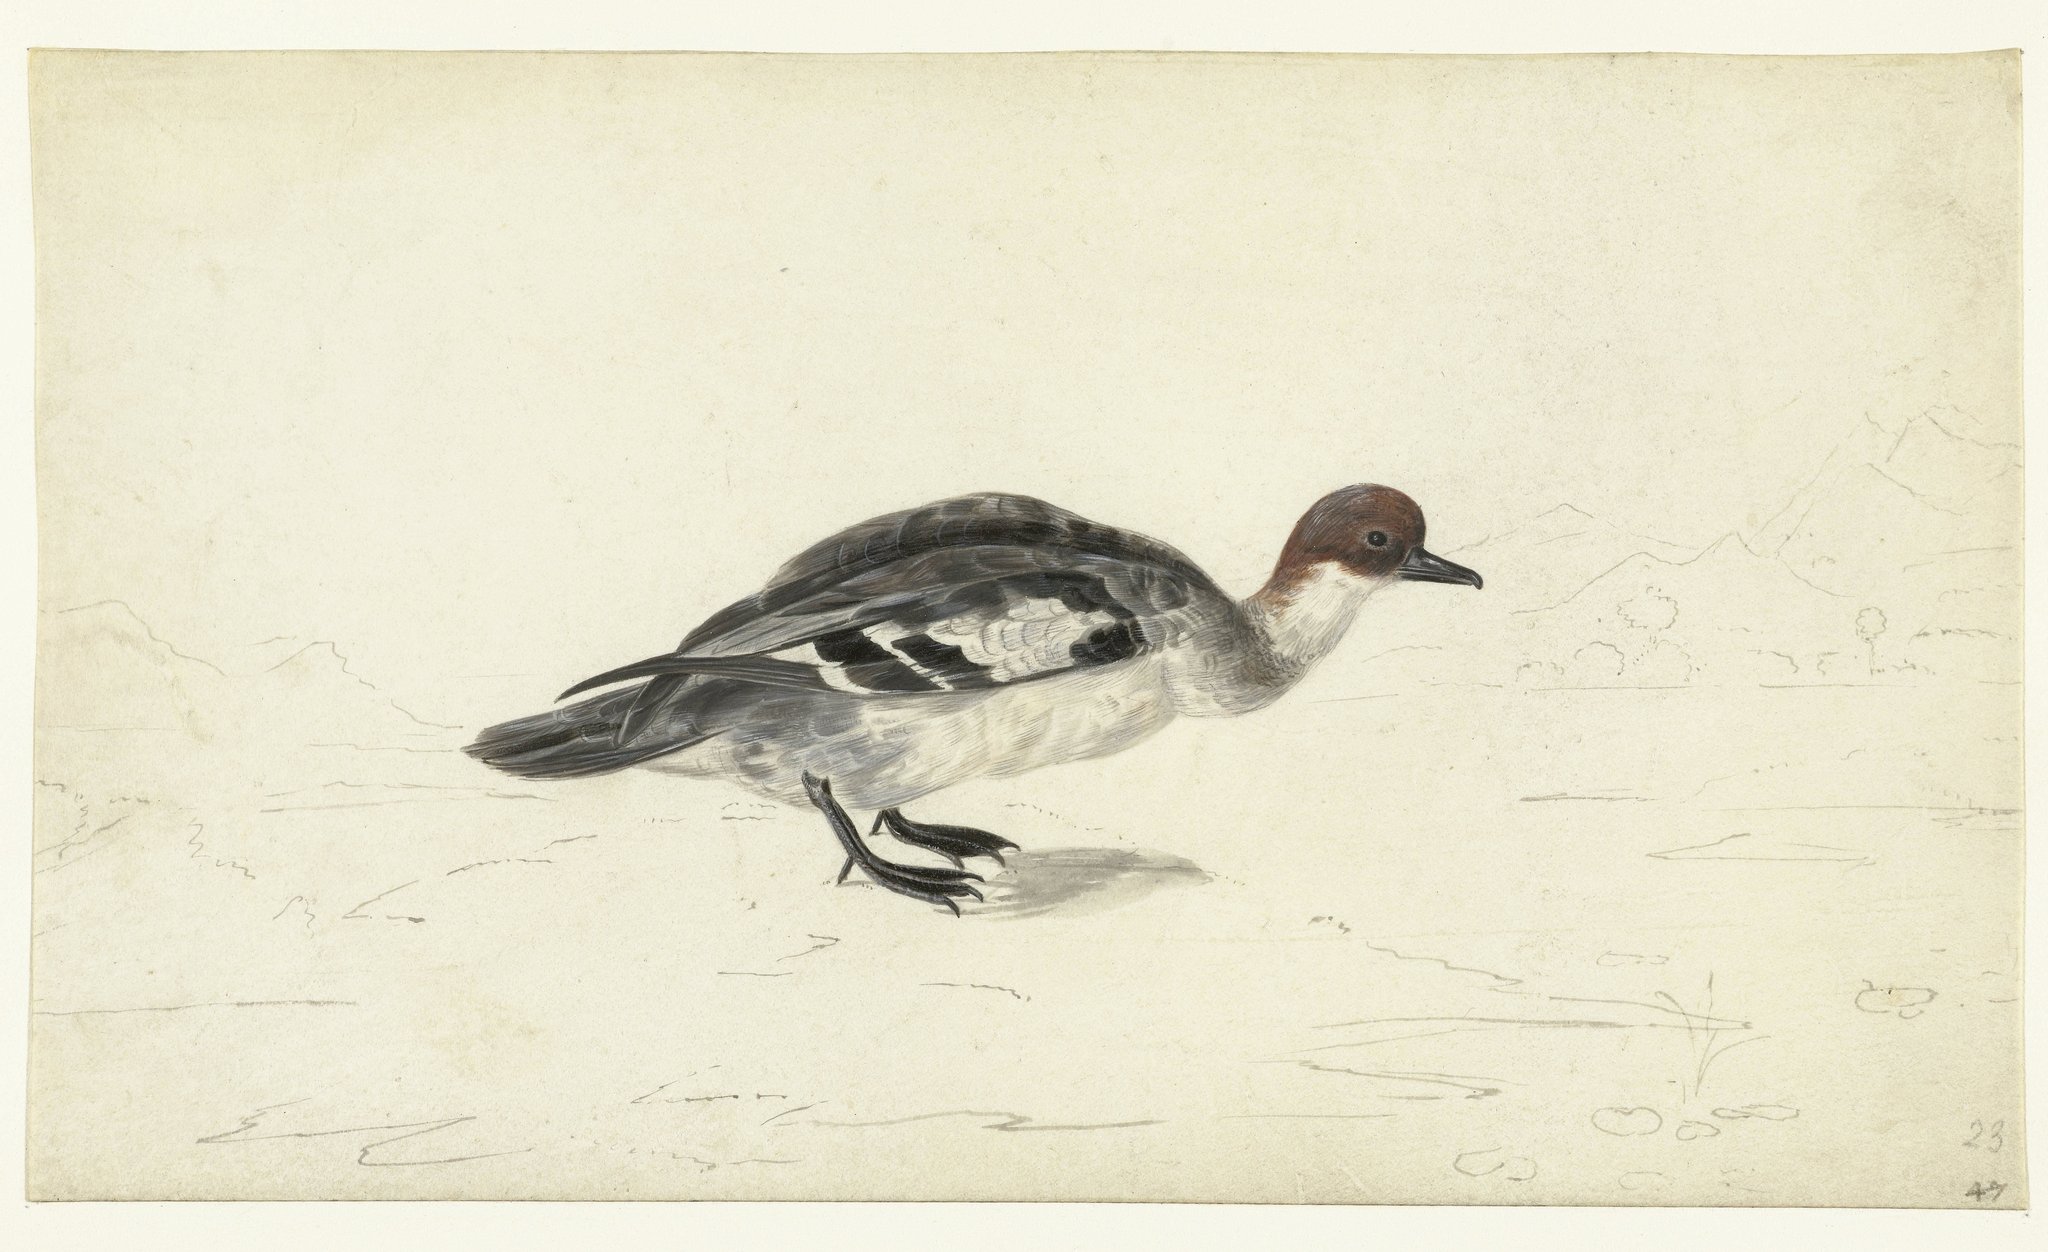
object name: drawing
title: Tafeleend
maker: Anonymous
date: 1600-1699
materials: paint, gouache, parchment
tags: water-birds: duck